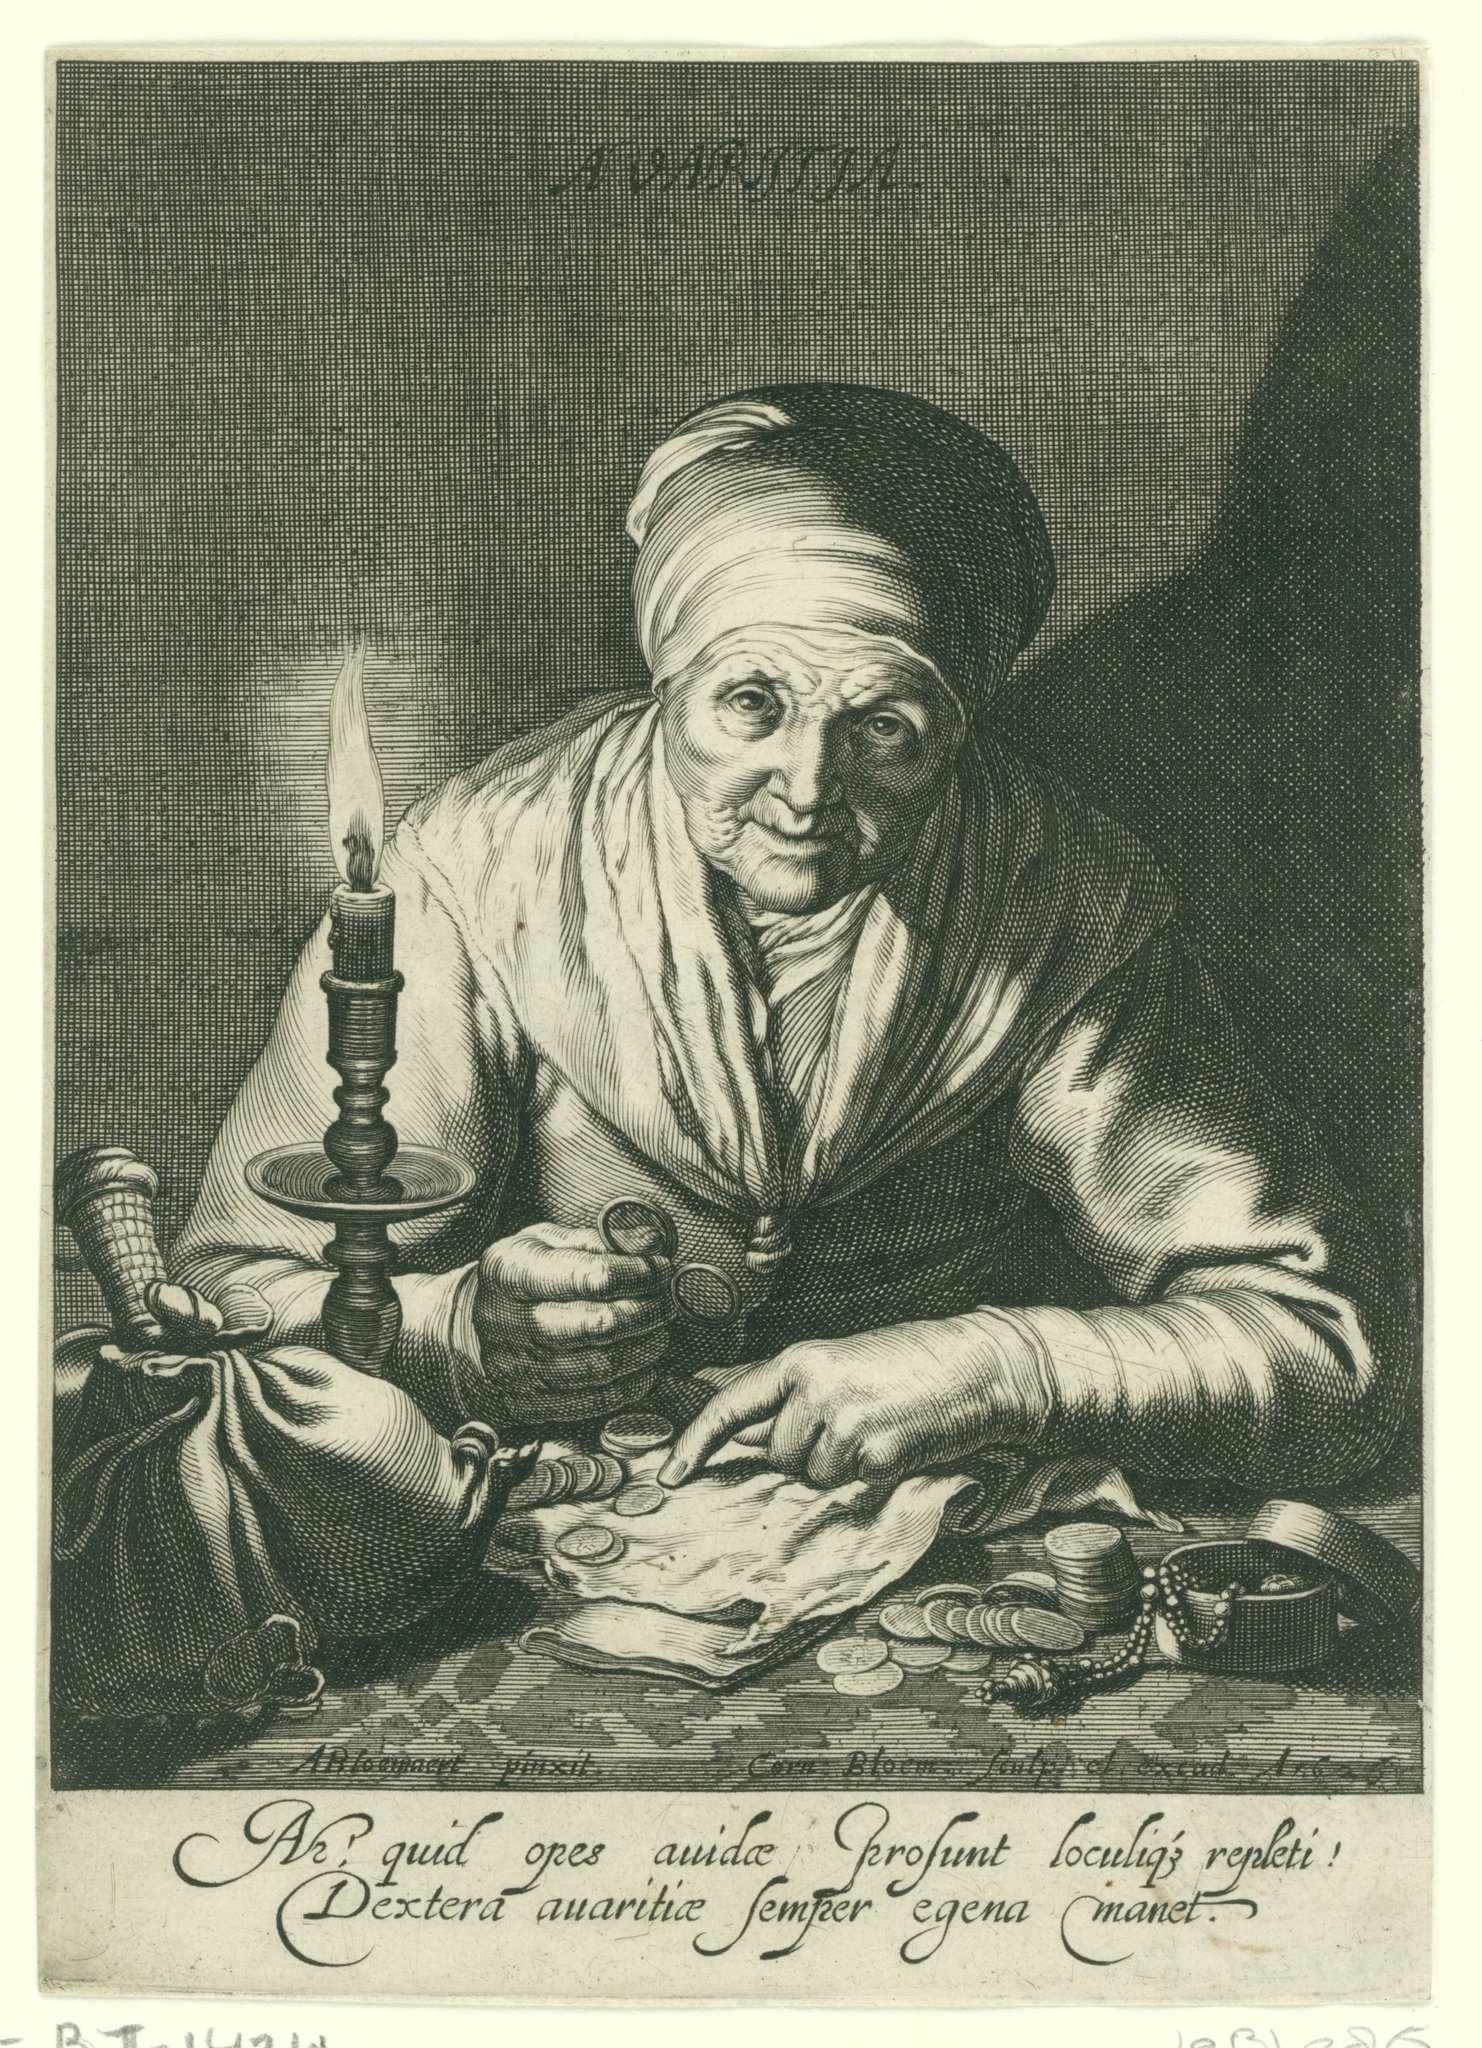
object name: print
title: Gierigheid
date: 1626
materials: paper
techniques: engraving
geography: utrecht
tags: covetousness; 'avaritia' (ripa) ~ personification of one of the seven deadly sins, jewel-box, money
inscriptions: collector's mark: Lugt 240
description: Een oude vrouw zit bij het licht van een kandelaar haar geld te tellen. Links op tafel een buidel, rechts een juwelendoosje. Met tweeregelig Latijns onderschrift.